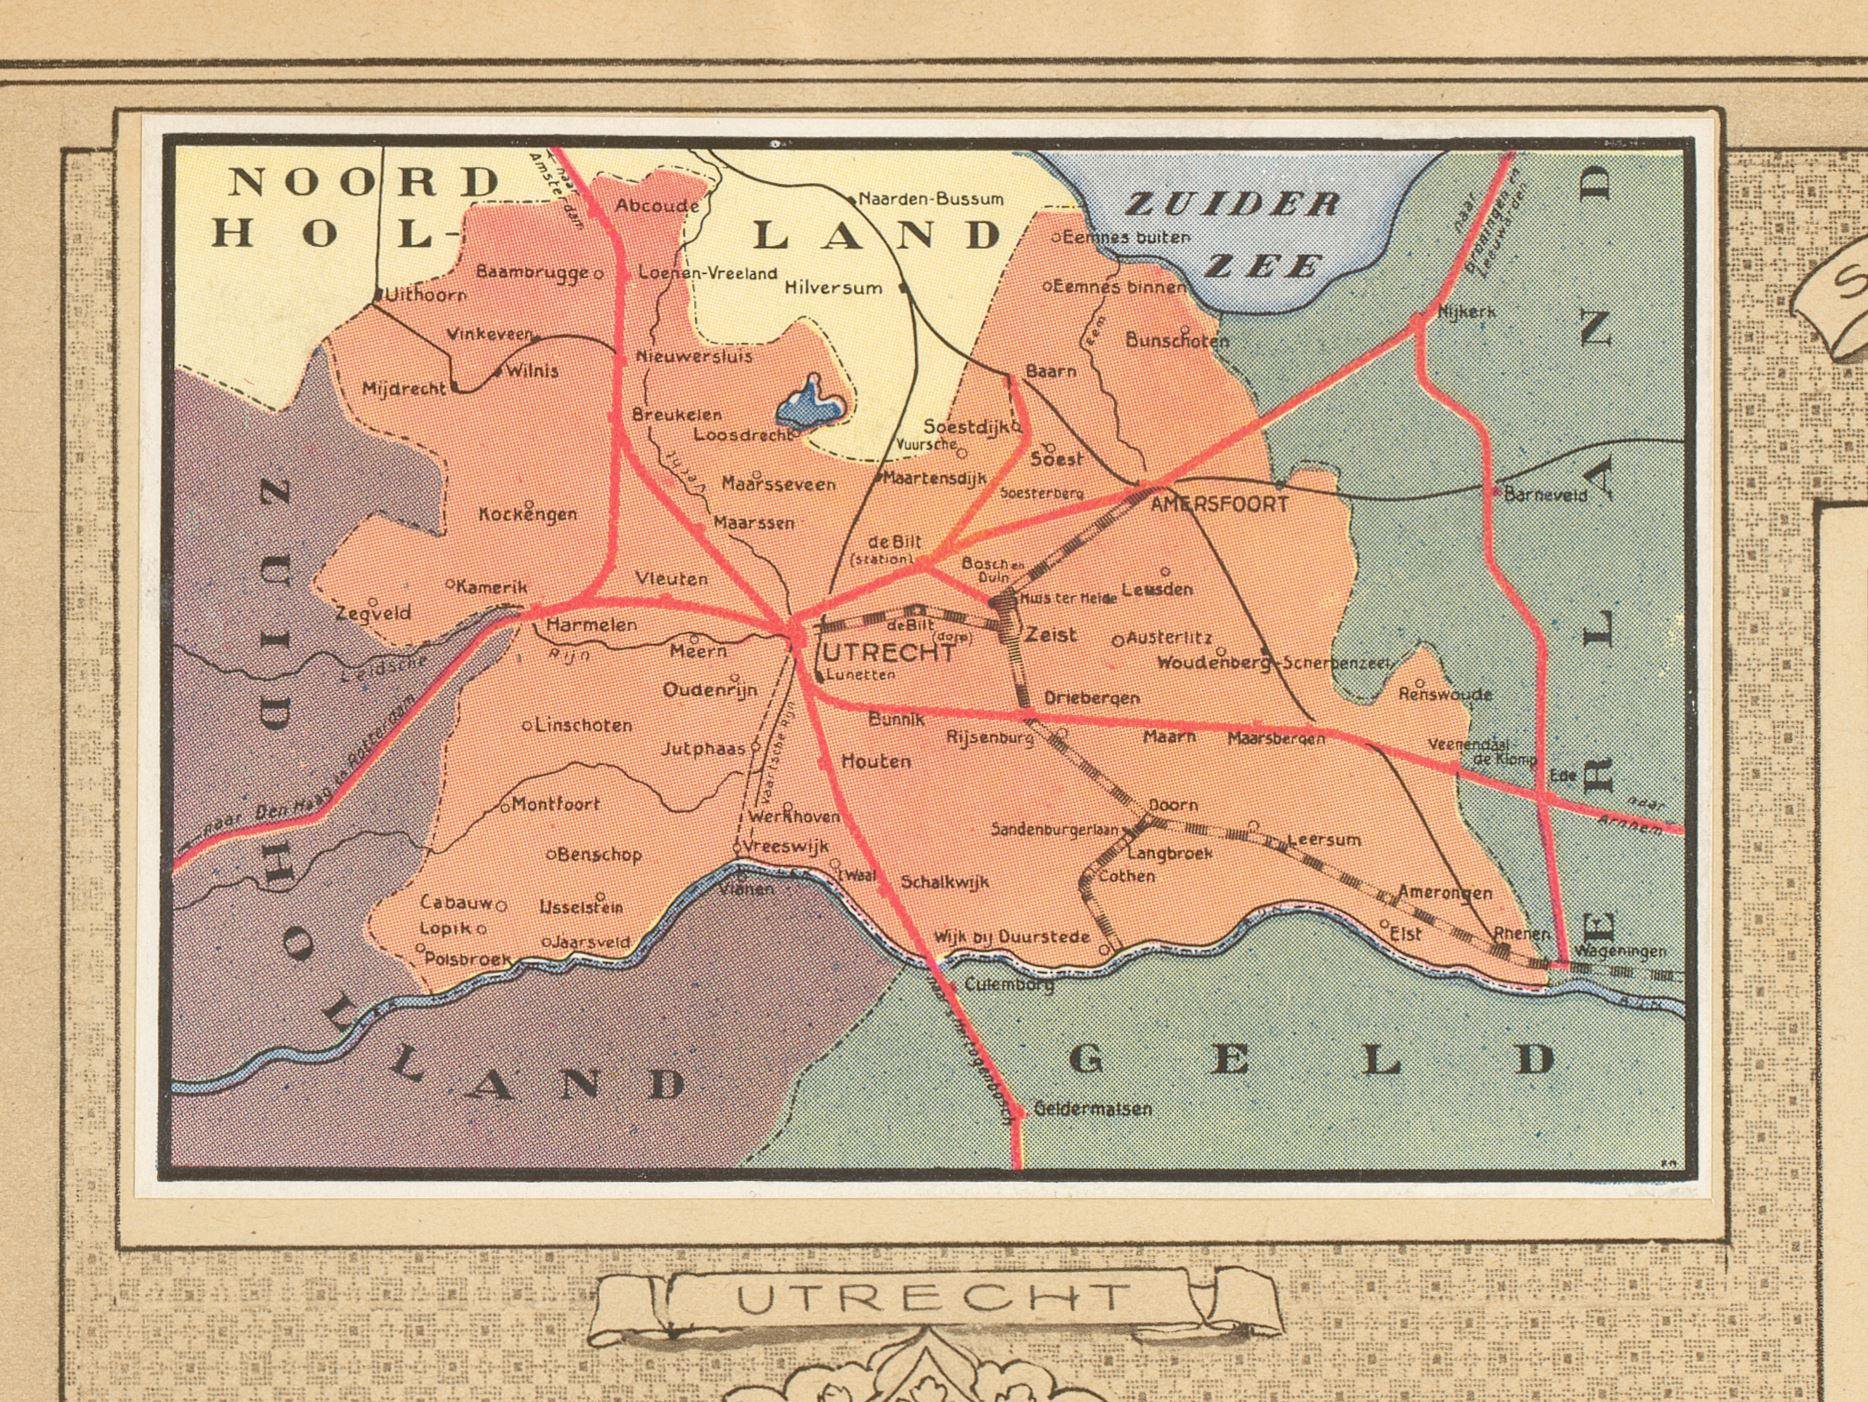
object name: album leaf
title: Spoorwegenkaart van Utrecht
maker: Anonymous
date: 1915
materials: paper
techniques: printing block, rotogravure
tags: maps of separate countries or regions, railway, tramway; rack railway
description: Deze prent maakt deel uit van een album.